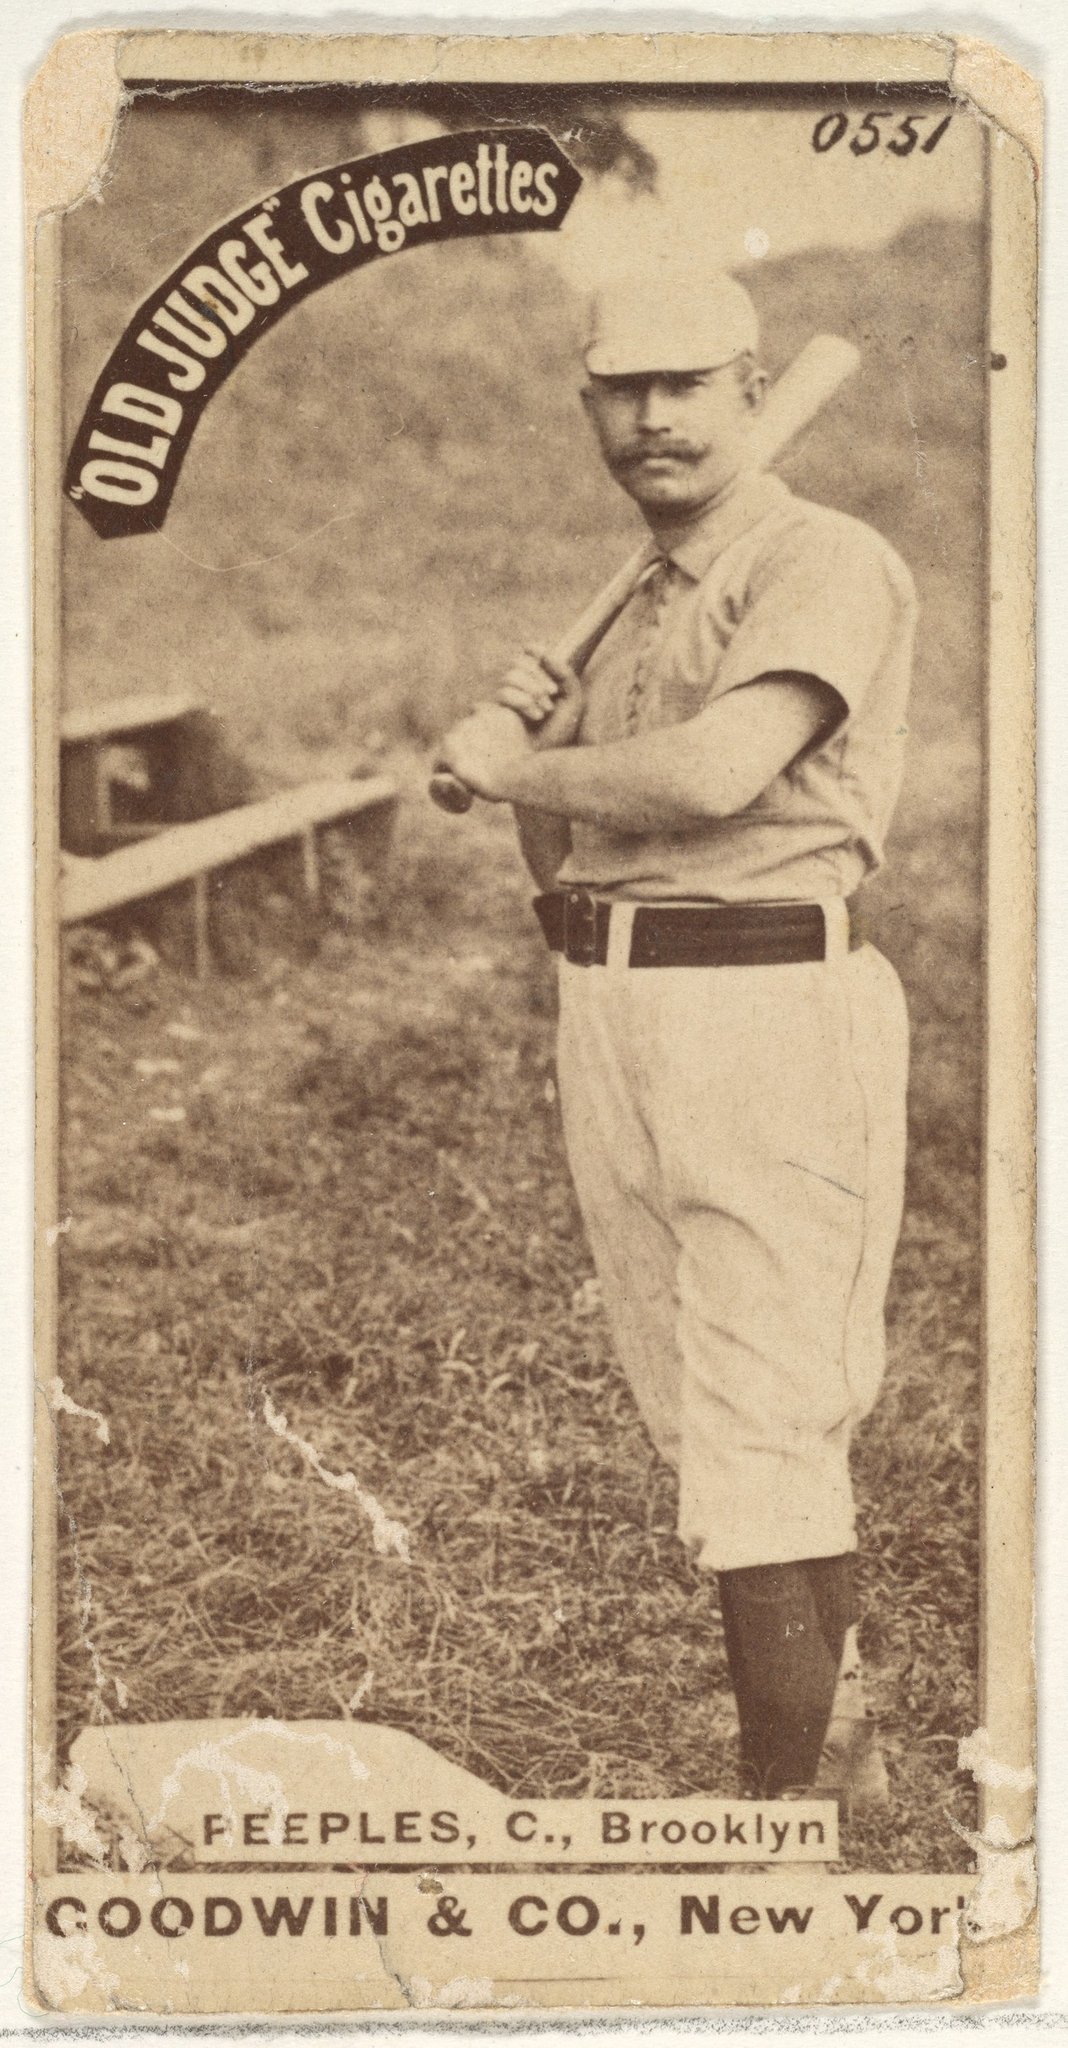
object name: baseball card, photograph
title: Peeples, Catcher, Brooklyn, from the Old Judge series (N172) for Old Judge Cigarettes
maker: goodwin & company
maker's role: publisher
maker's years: 1850-1950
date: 1887-1890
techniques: albumen silver print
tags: men,portraits,baseball,athletes